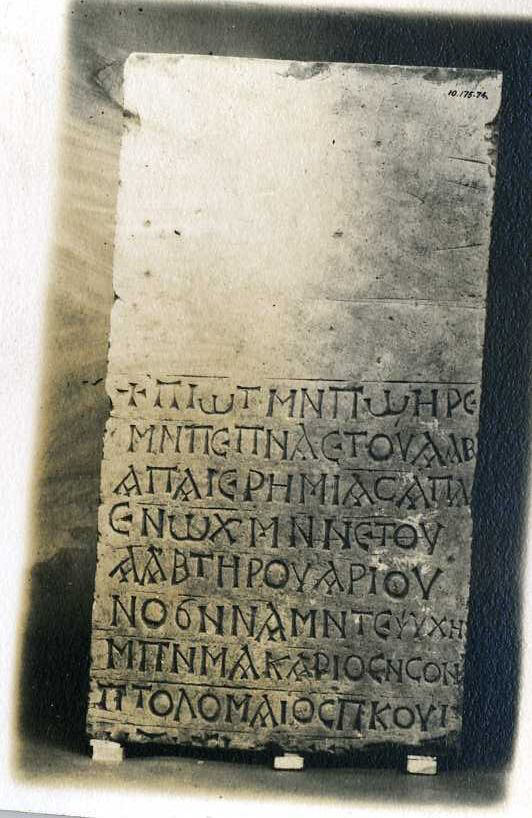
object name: stele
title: Inscribed Stele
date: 501-700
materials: limestone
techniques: incising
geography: egypt